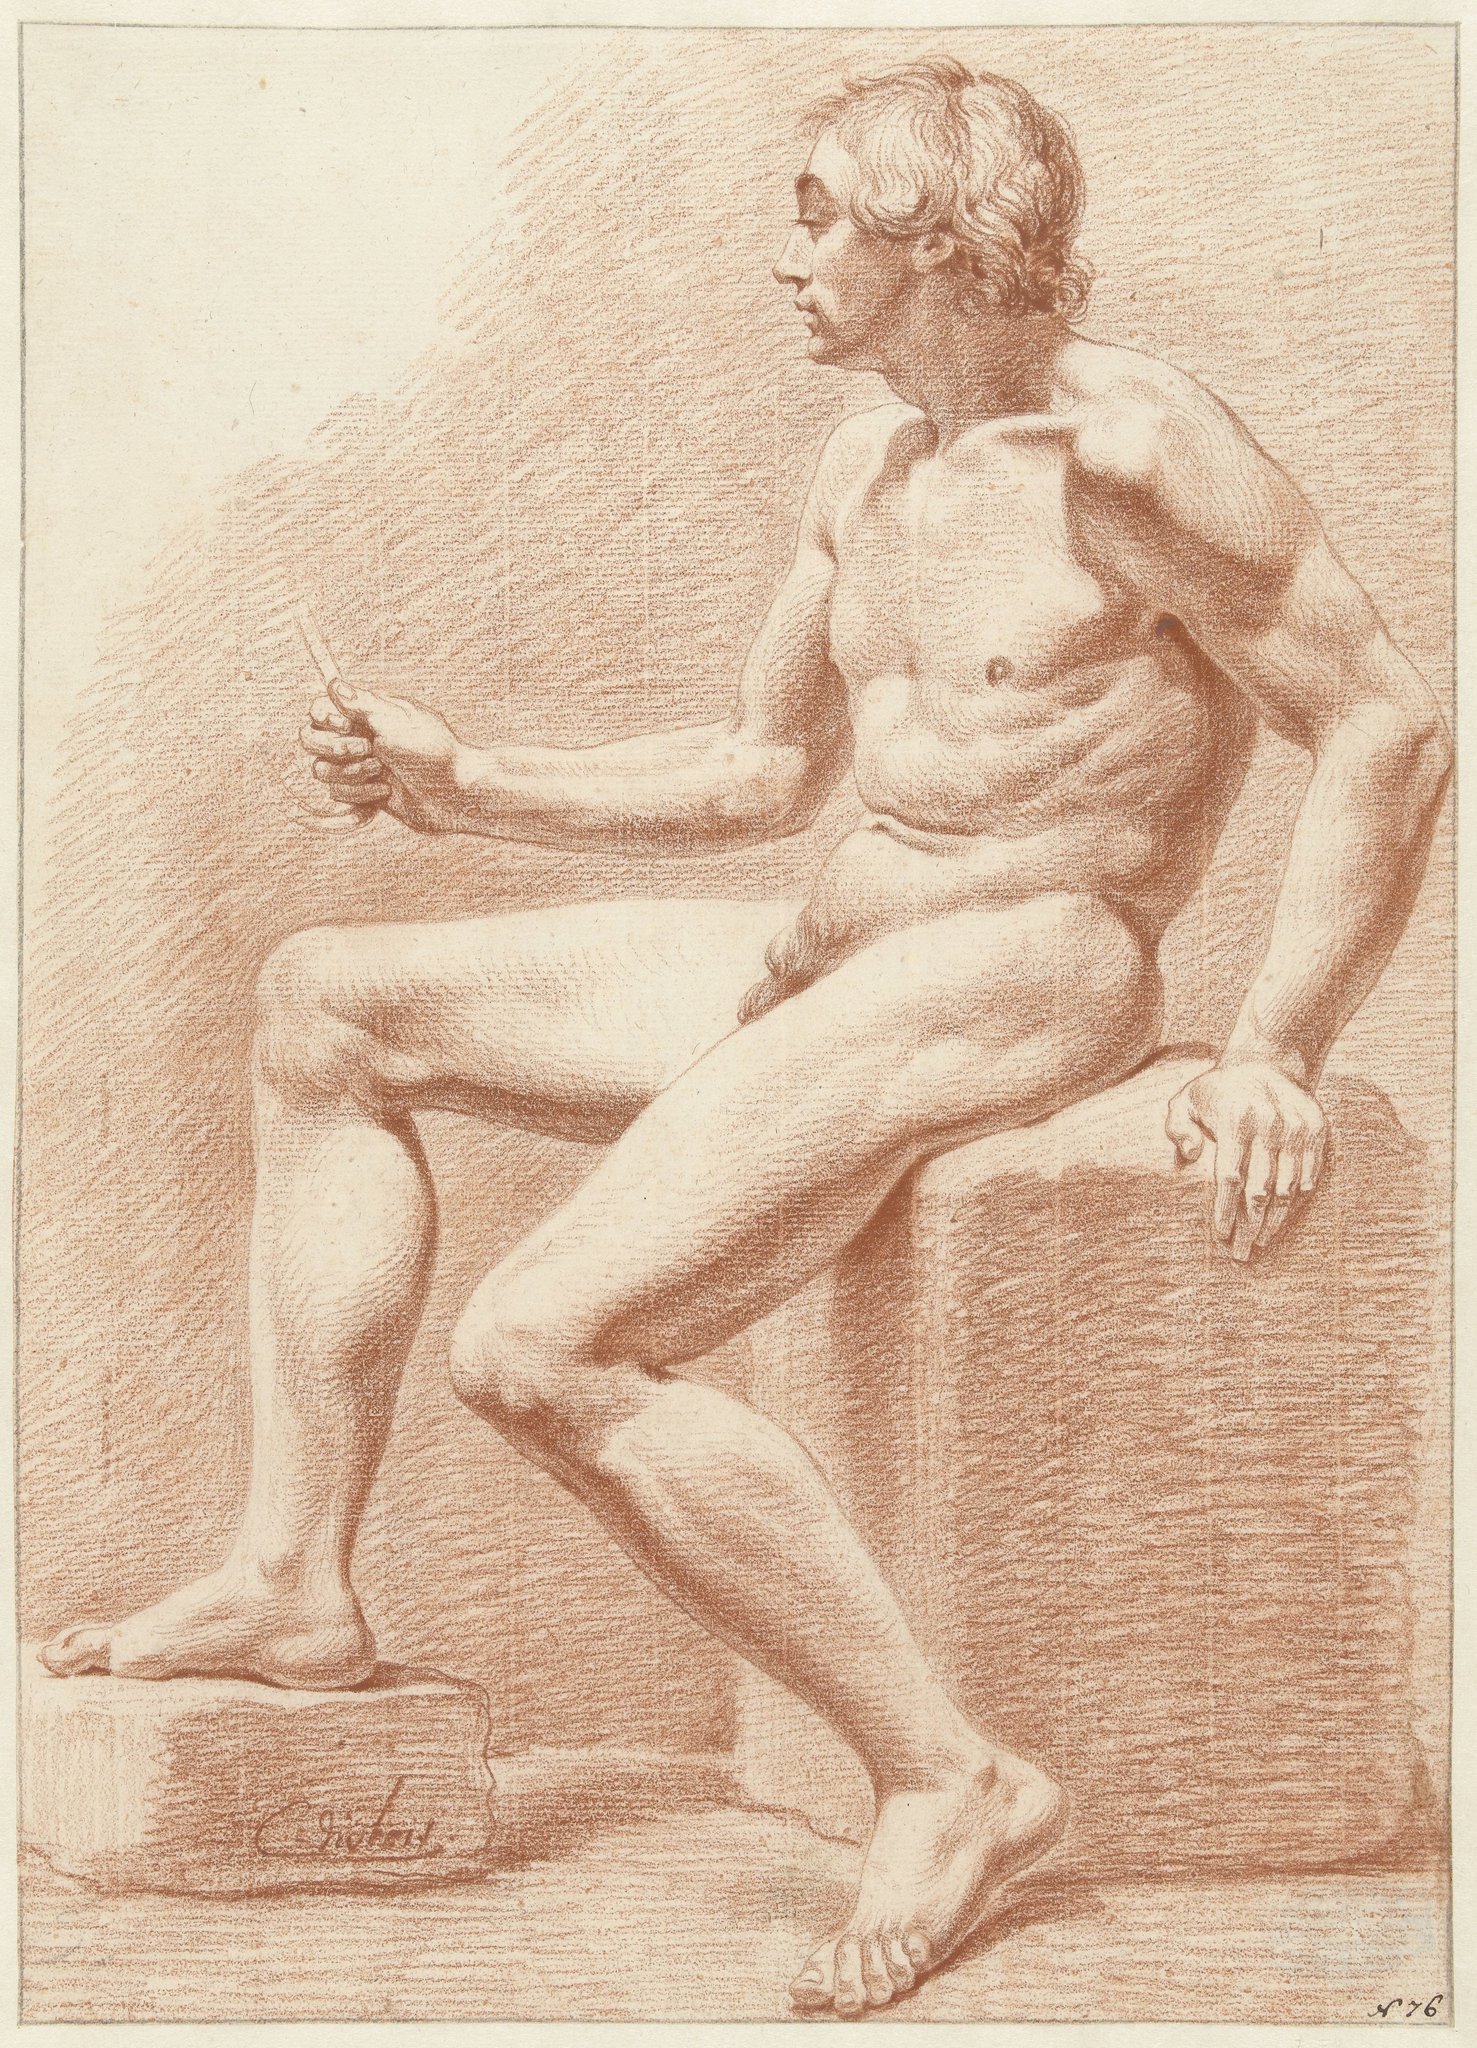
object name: drawing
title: Zittend mannelijk naakt, van opzij gezien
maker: chrétien dubois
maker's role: draughtsman, print maker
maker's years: 1765-1837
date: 1775-1837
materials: chalk, paper